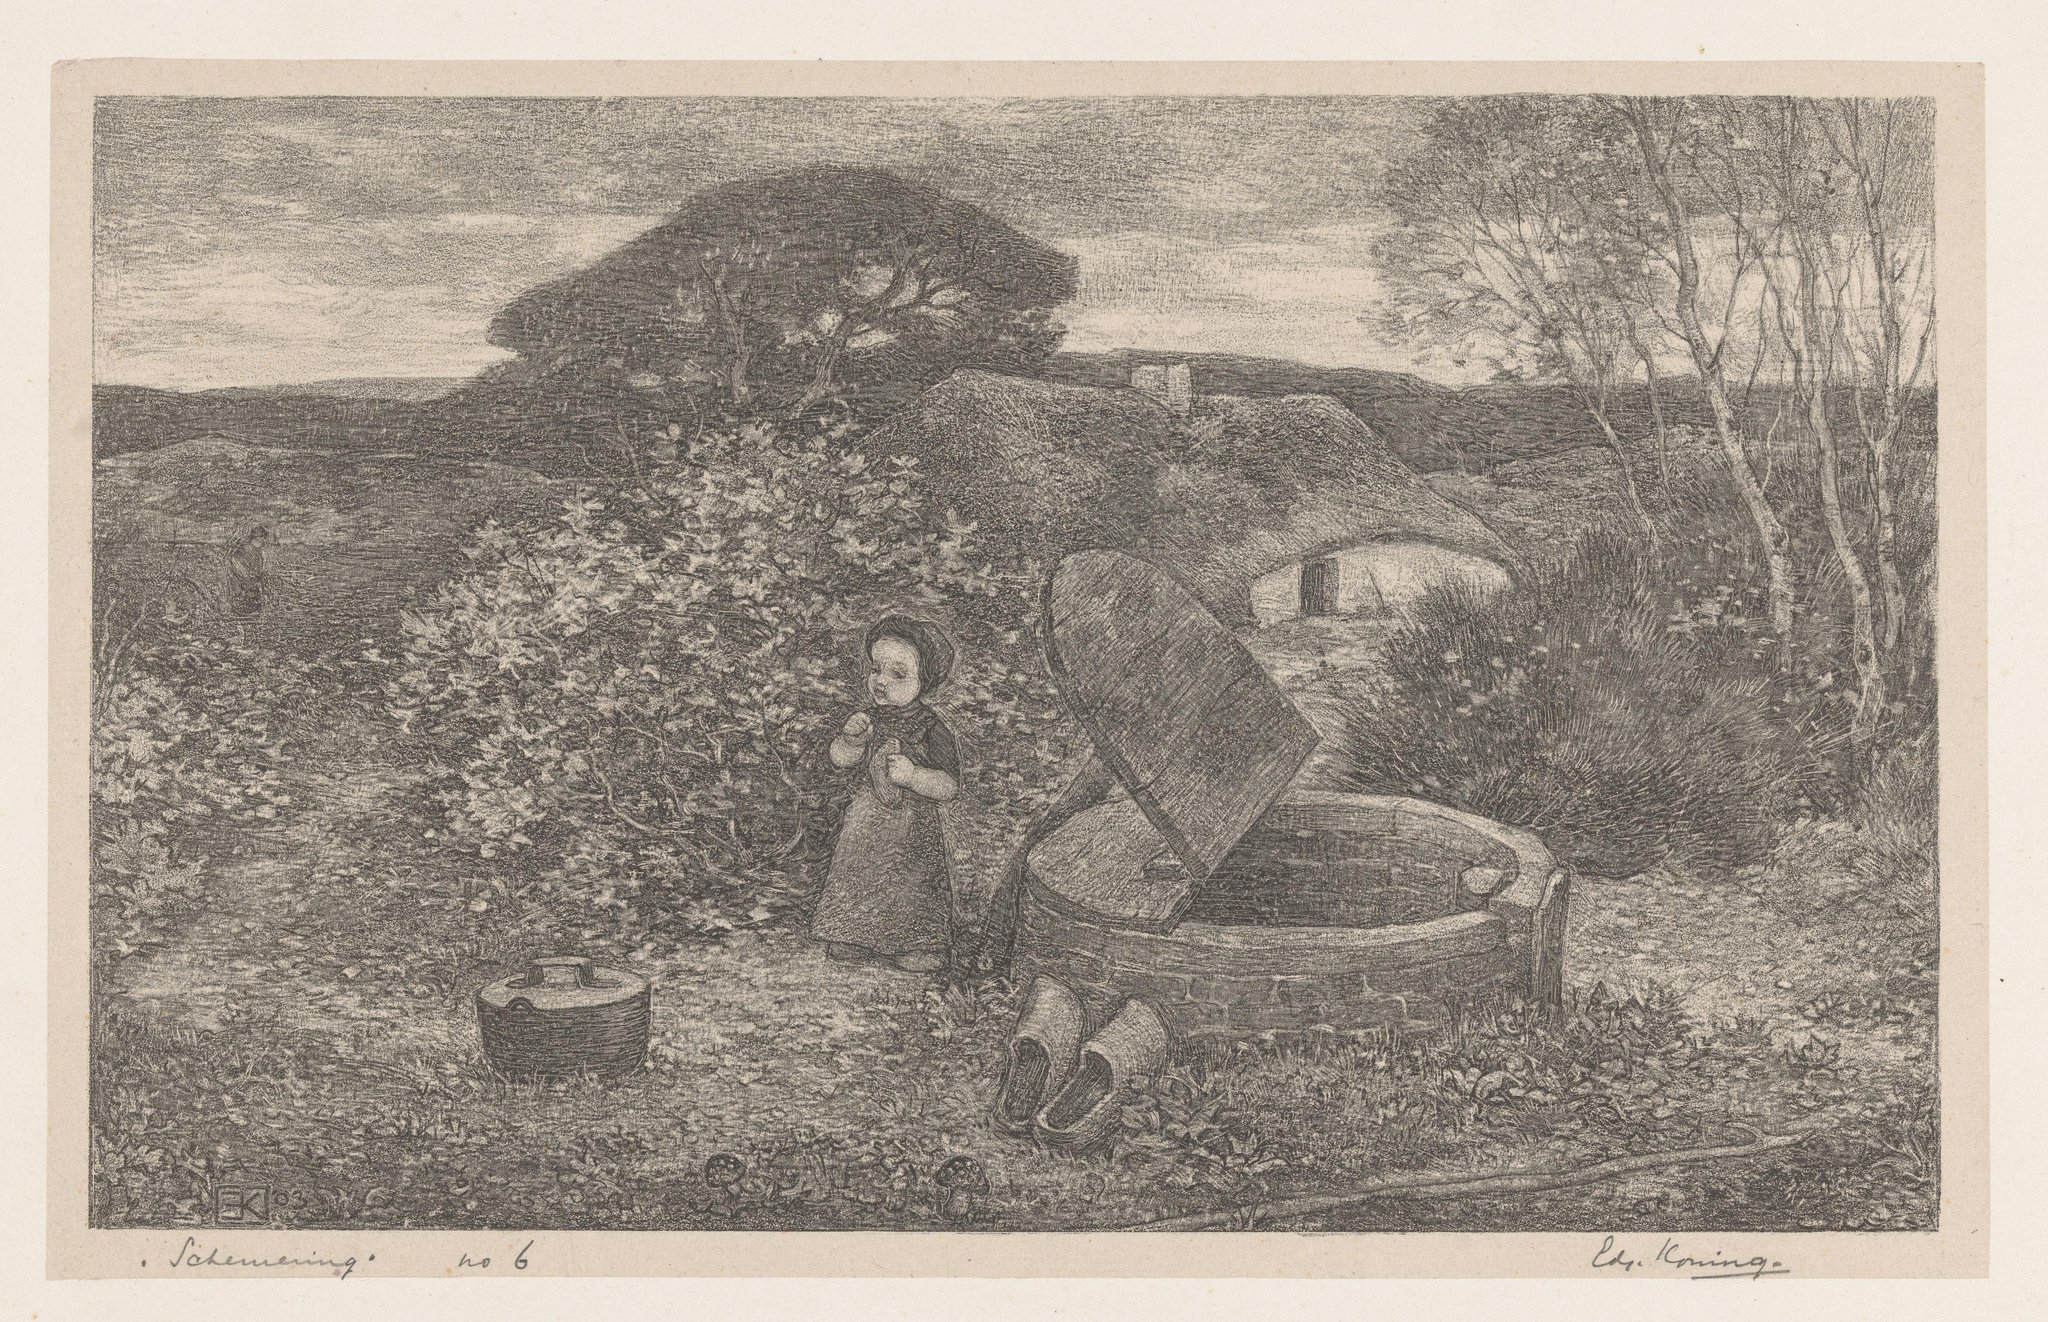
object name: print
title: Schemering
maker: edzard koning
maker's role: draughtsman, print maker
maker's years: 1869-1954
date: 1903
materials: paper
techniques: lithograph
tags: well, meadow, pasture, child (at home)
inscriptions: collector's mark: Lugt 2760, number: ‘6’, collector's mark: Lugt 2228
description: Een heidelandschap met een kind, een ketel en een paar klompen naast een waterput. Op de achtergrond een huis met rieten dak.